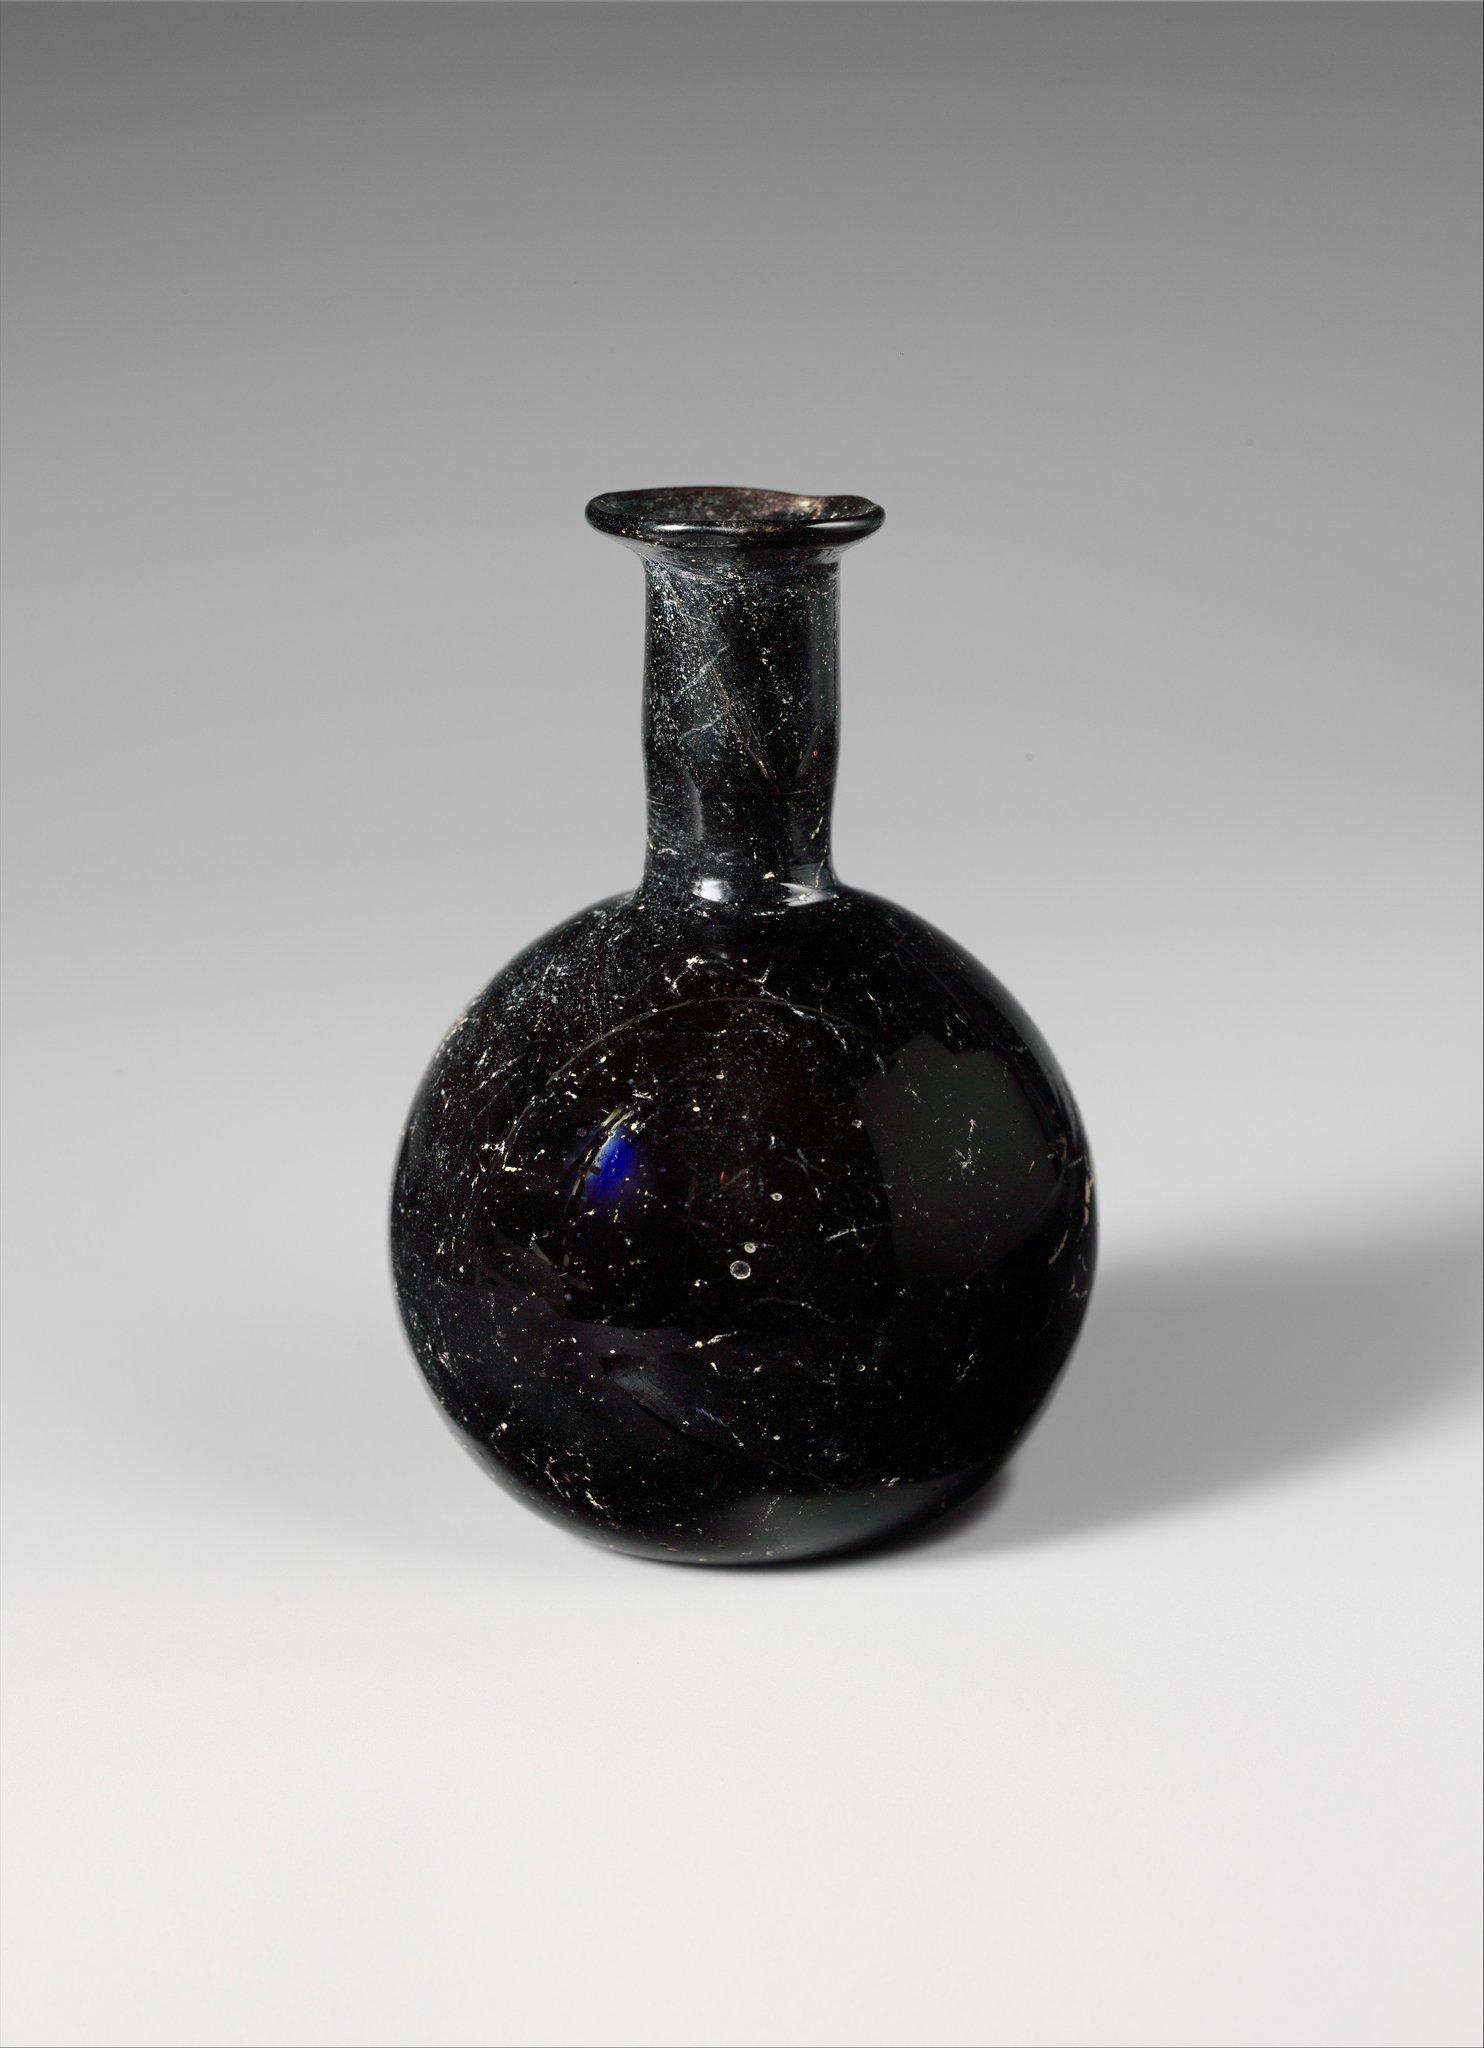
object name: perfume bottle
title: Glass perfume bottle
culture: roman, cypriot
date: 1-100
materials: glass